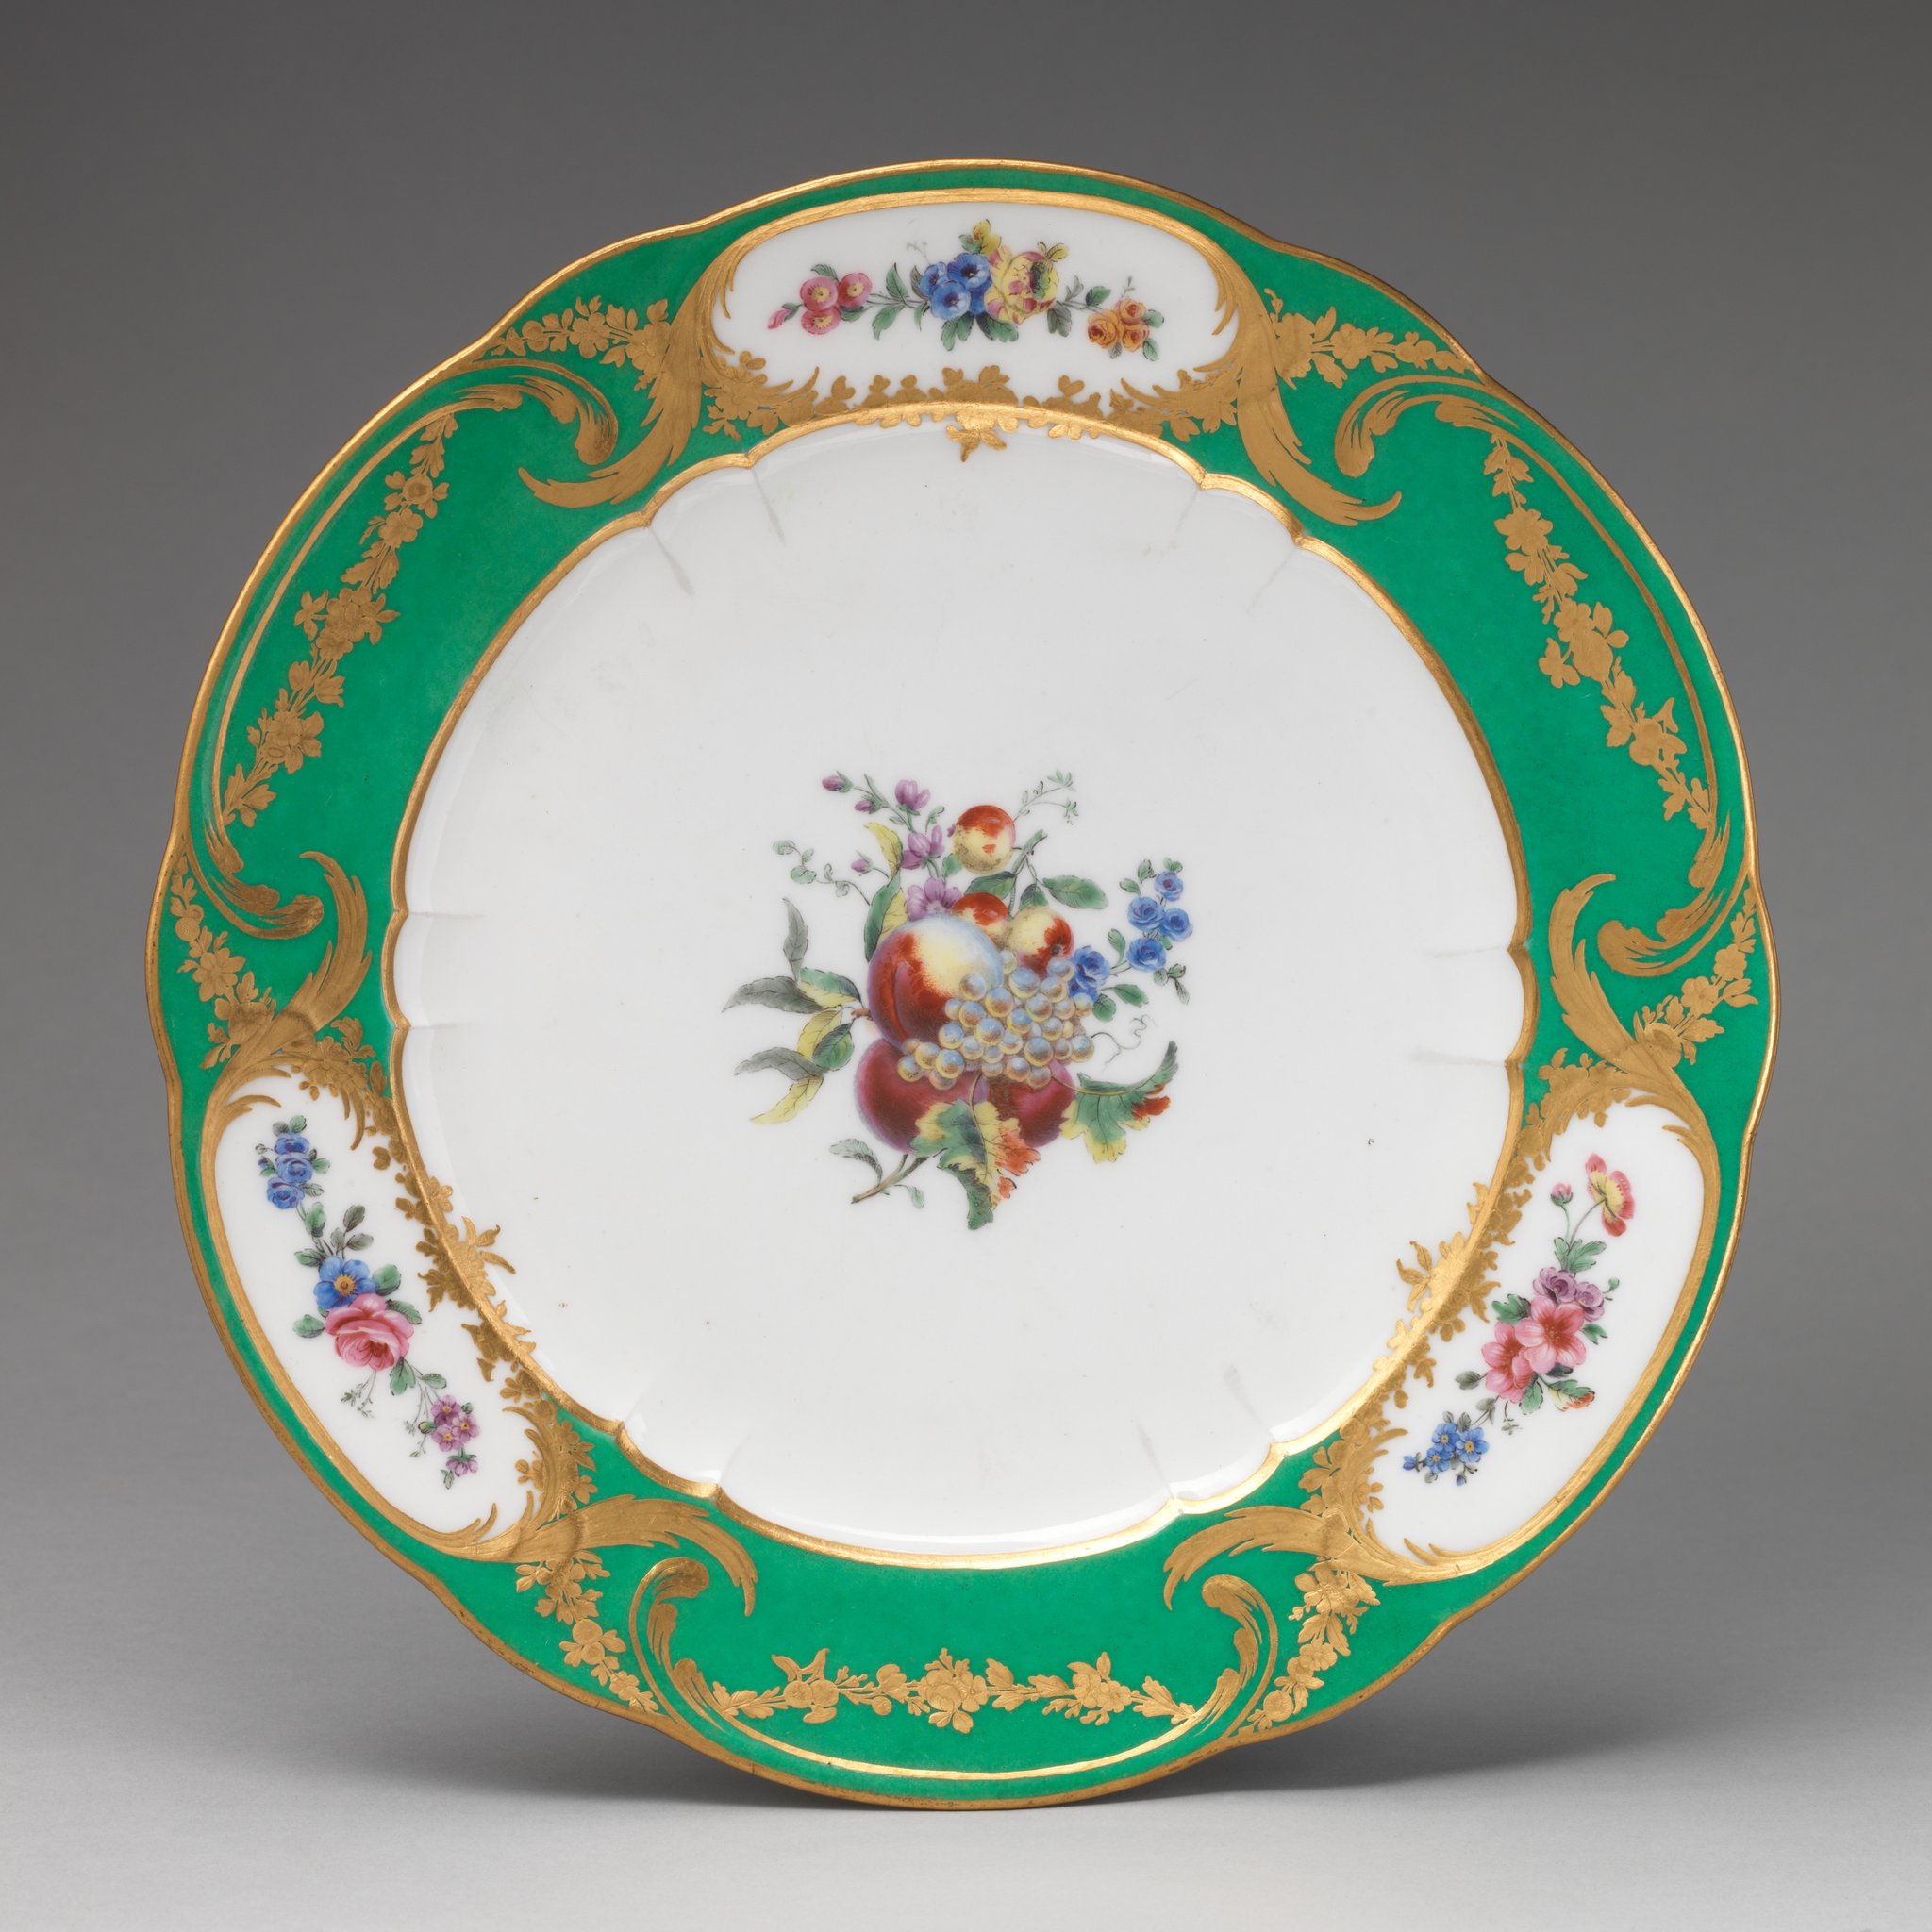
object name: plate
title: Plate (assiette à palmes) (1 of 102) (part of a service)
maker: sèvres manufactory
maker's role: manufactory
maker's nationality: french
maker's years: 1740-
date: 1780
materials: soft paste porcelain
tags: flowers